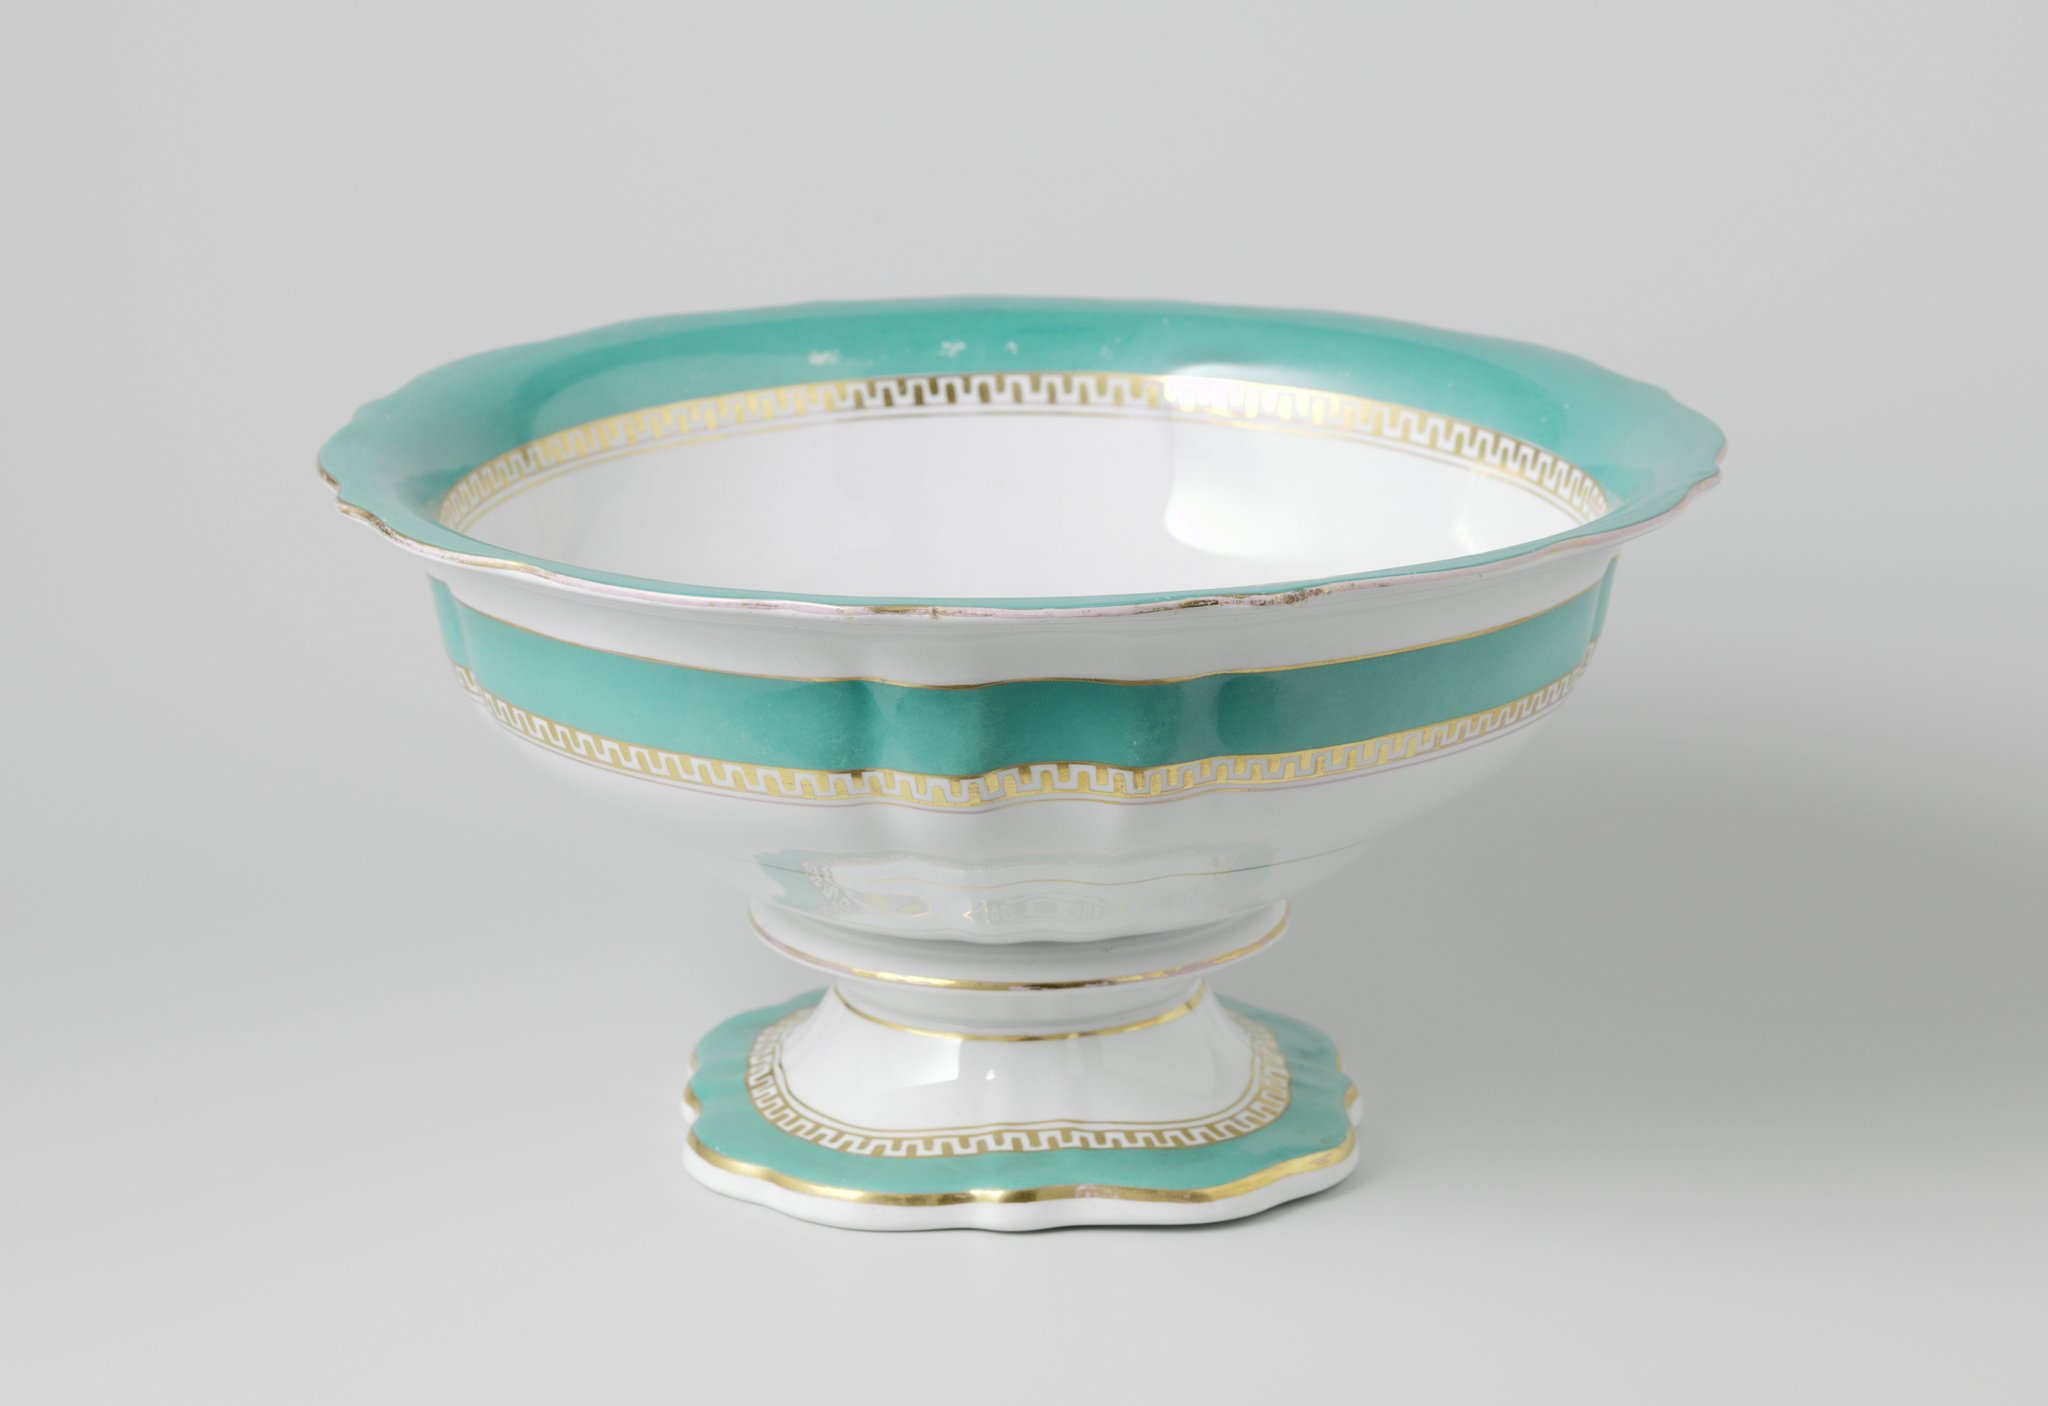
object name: dish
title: Schaal op voet met groene rand en gouden Griekse band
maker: petrus regout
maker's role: plateelbakker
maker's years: 1801-1879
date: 1865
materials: earthenware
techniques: transfer decoration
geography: maastricht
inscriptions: check stamp: ‘P. REGOUT // MAASTRICHT // 9X’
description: Schaal op voet van aardewerk, geschulpt, met groene rand en gouden Griekse band.